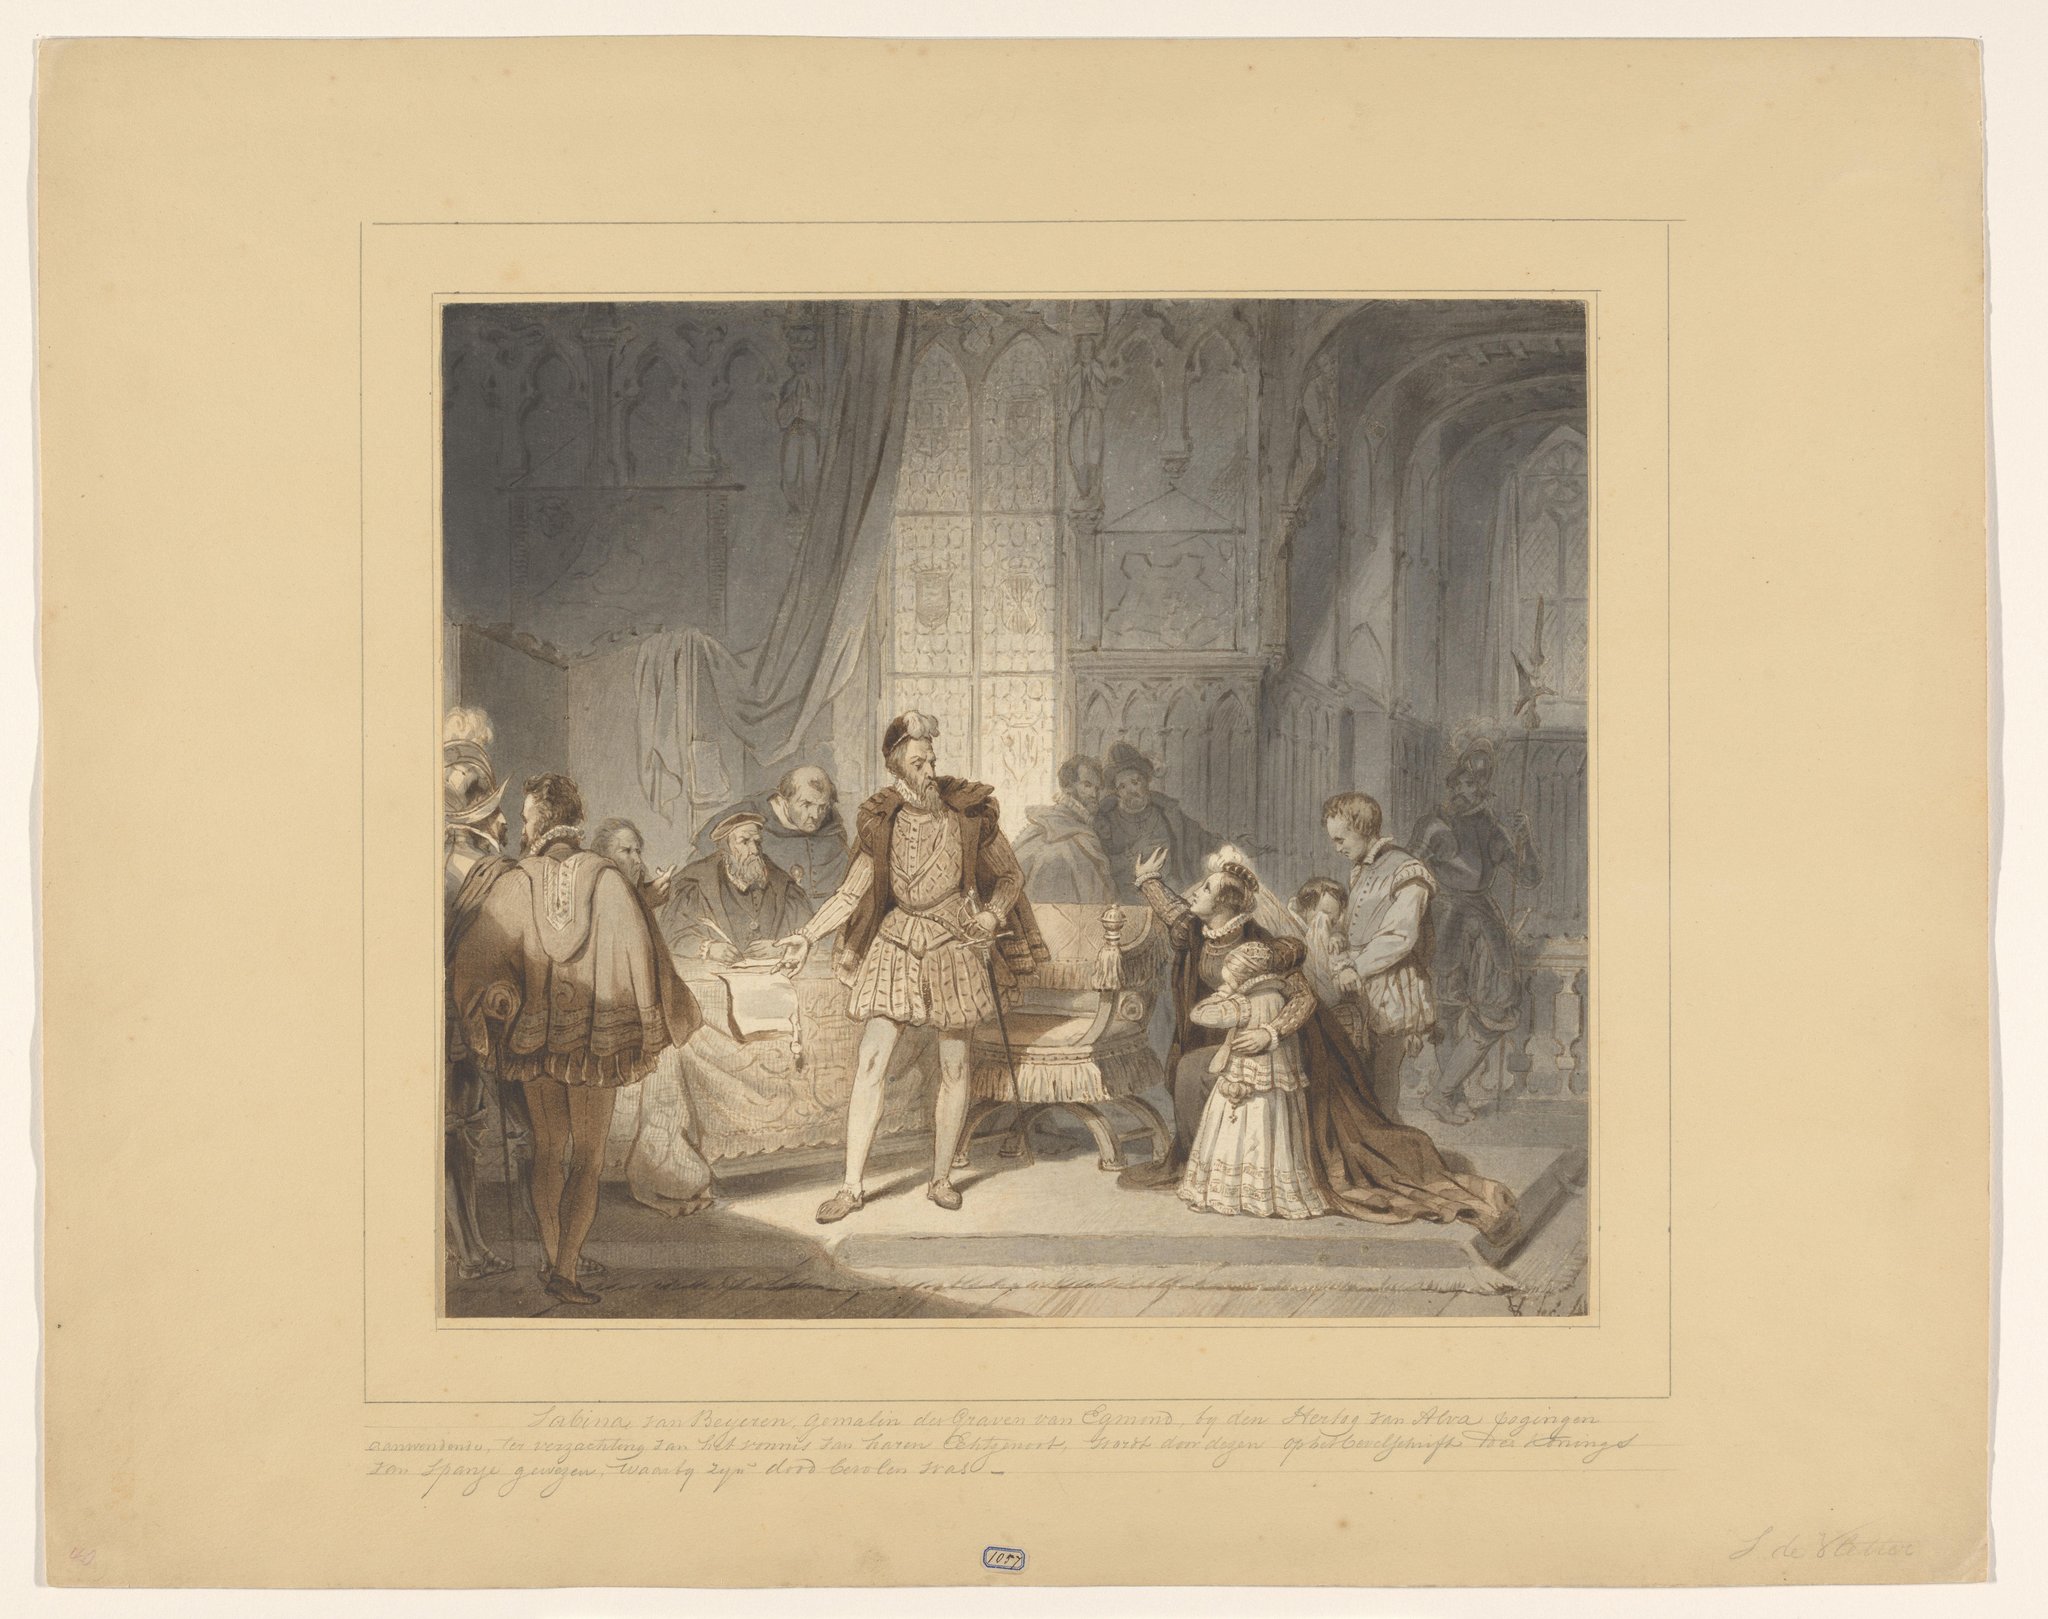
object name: drawing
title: Sabina van Beieren smeekt de hertog van Alva om het leven van haar echtgenoot, de graaf van Egmond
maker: samuel de vletter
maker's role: draughtsman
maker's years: 1816-1844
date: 1841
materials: ink, paper, pencil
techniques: brush, pen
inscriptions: signature and date: ‘SV [monogram] fec. 41’